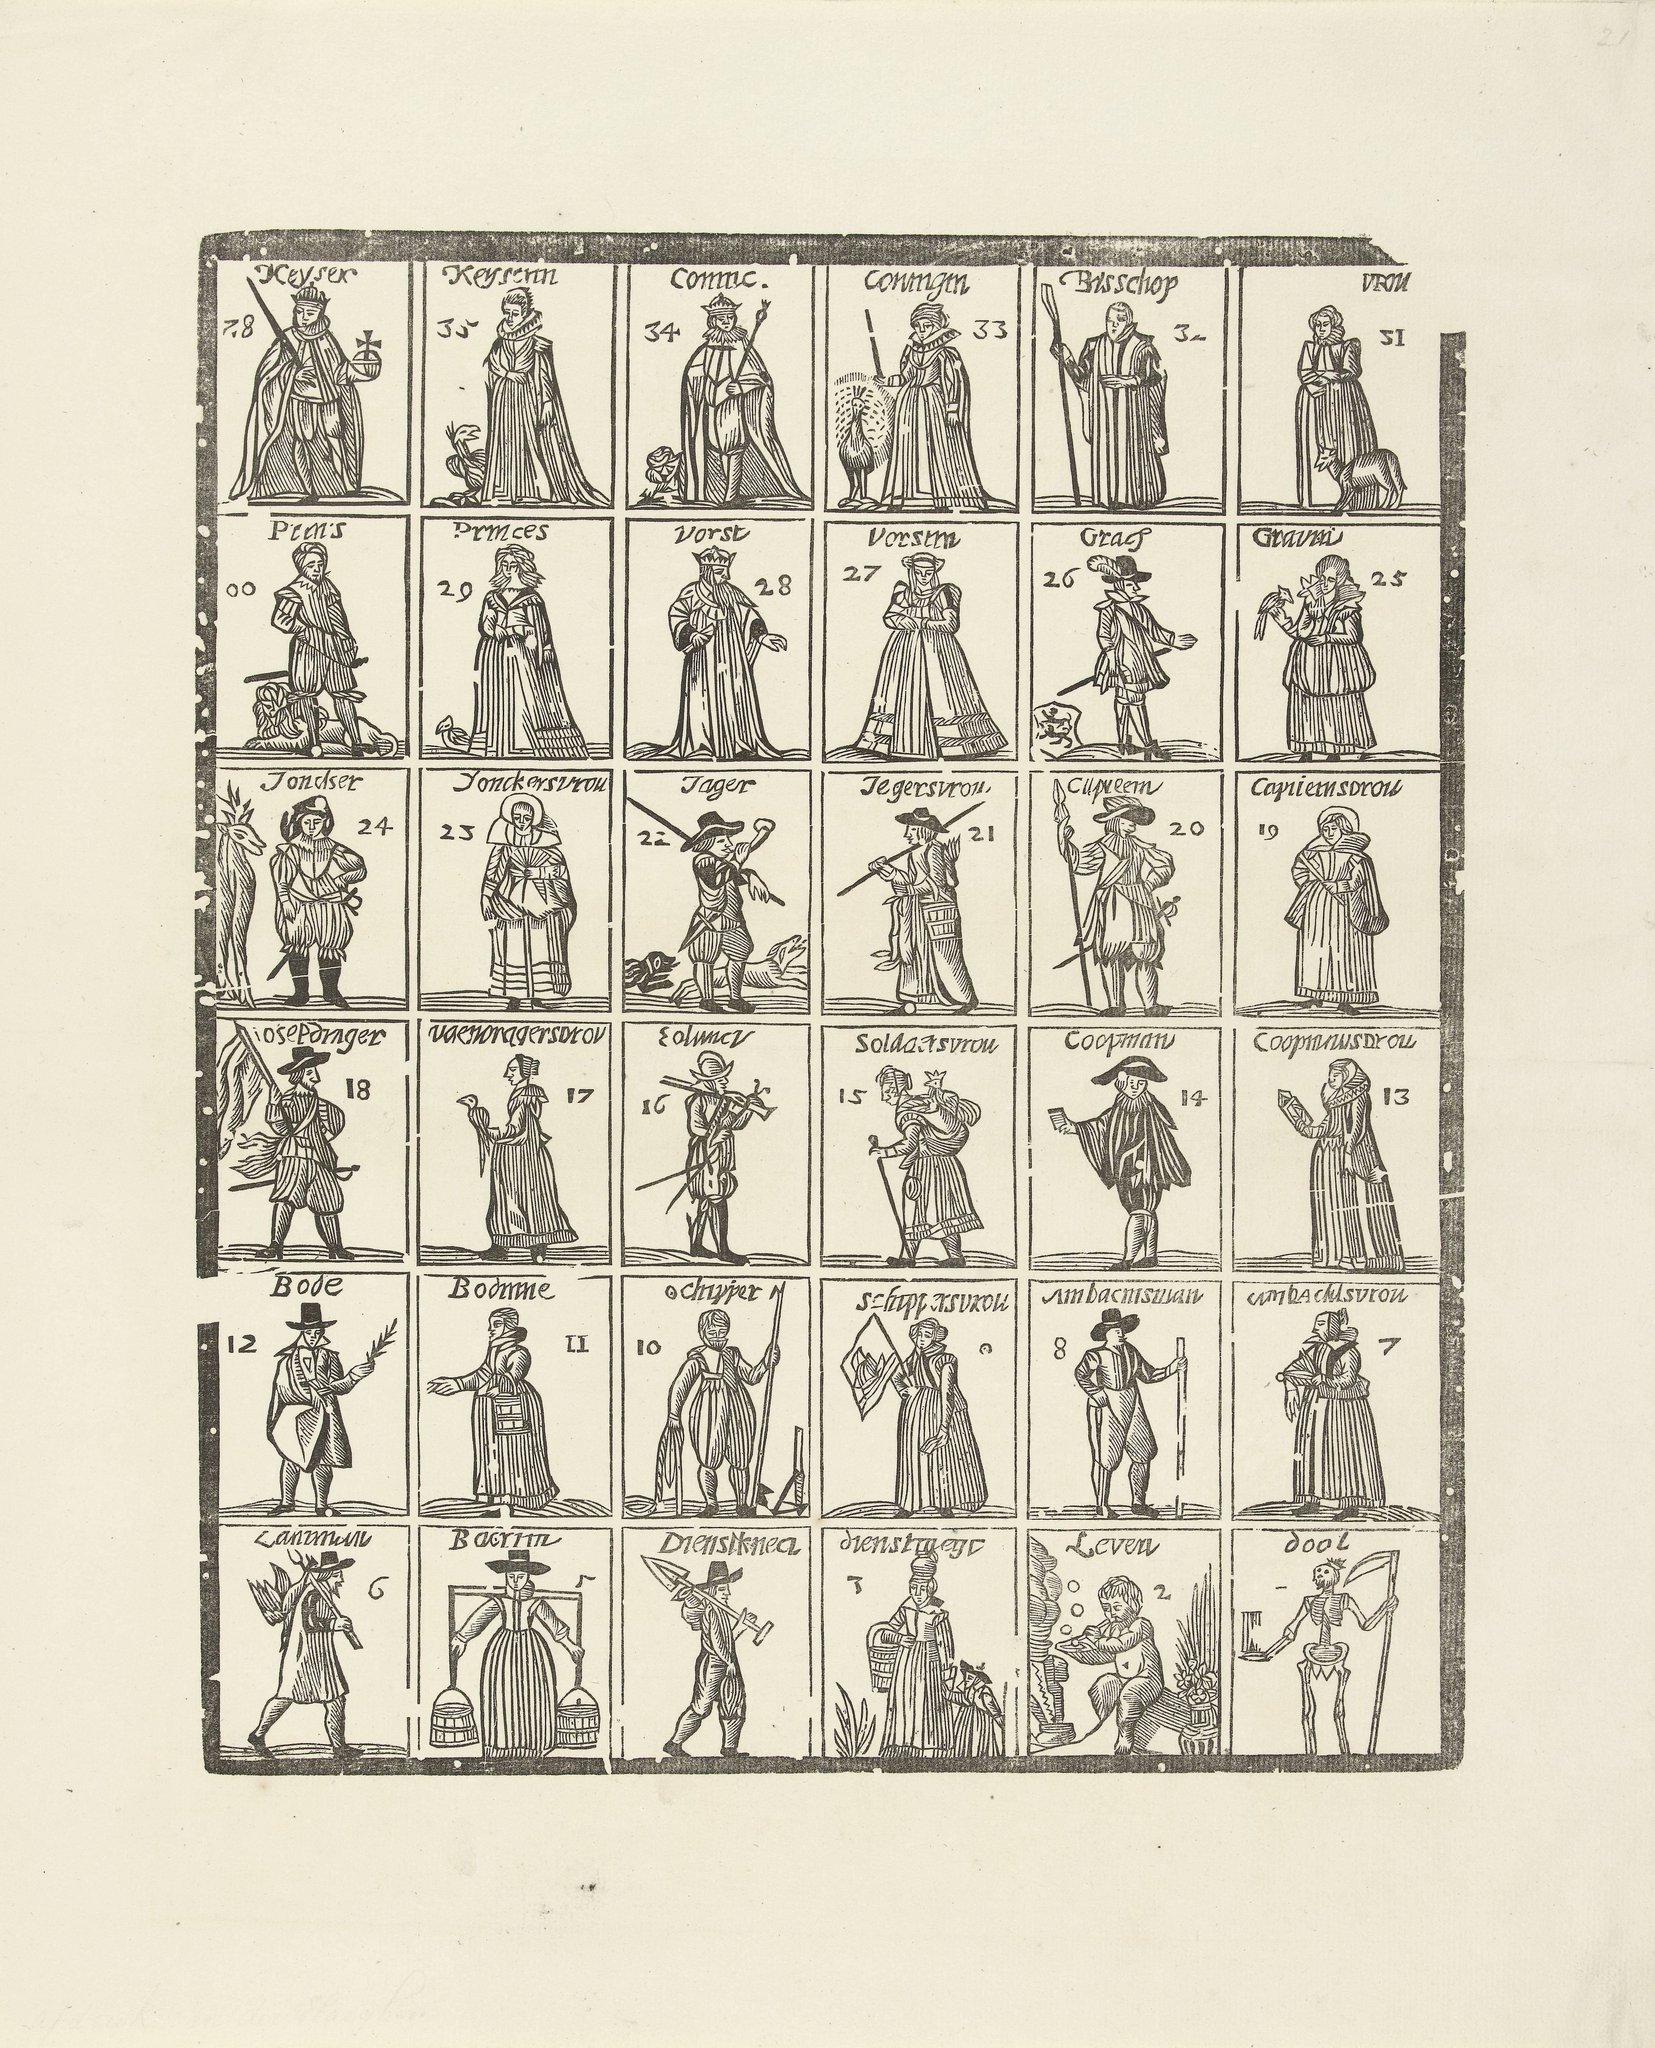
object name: print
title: Beroepen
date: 1700-1725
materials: paper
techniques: woodcut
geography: ghent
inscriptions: collector's mark: Lugt 2760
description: Blad met 36 voorstellingen van beroepen van mannen en vrouwen, van keizer tot de Dood. Elk plaatje met naam en nummer.